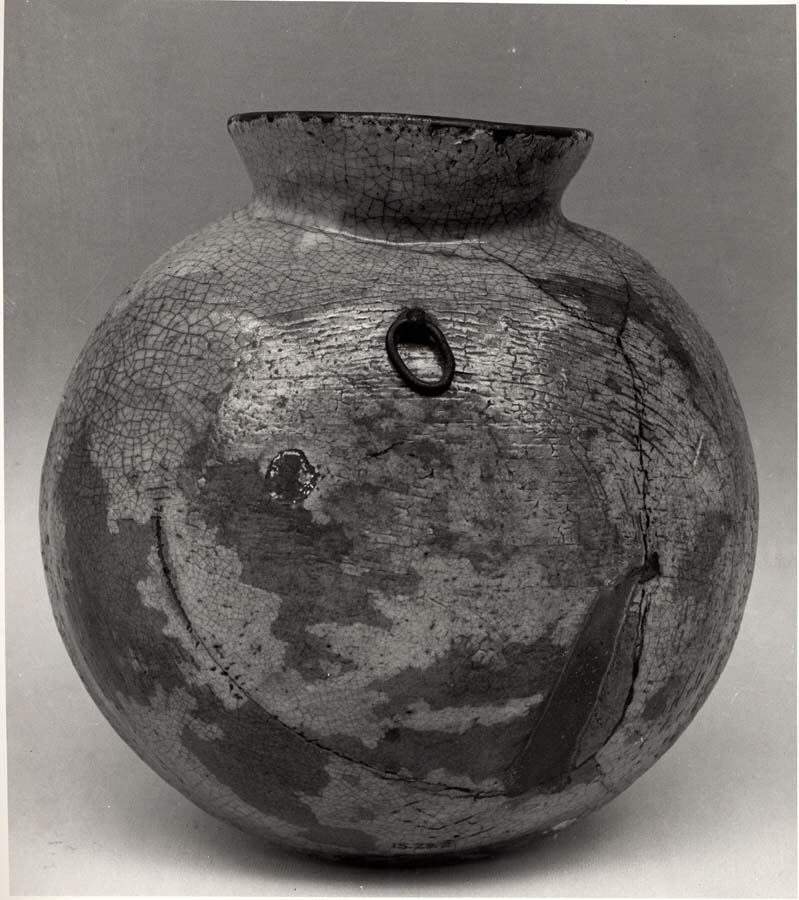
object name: jar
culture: korean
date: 1901-1933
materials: pottery